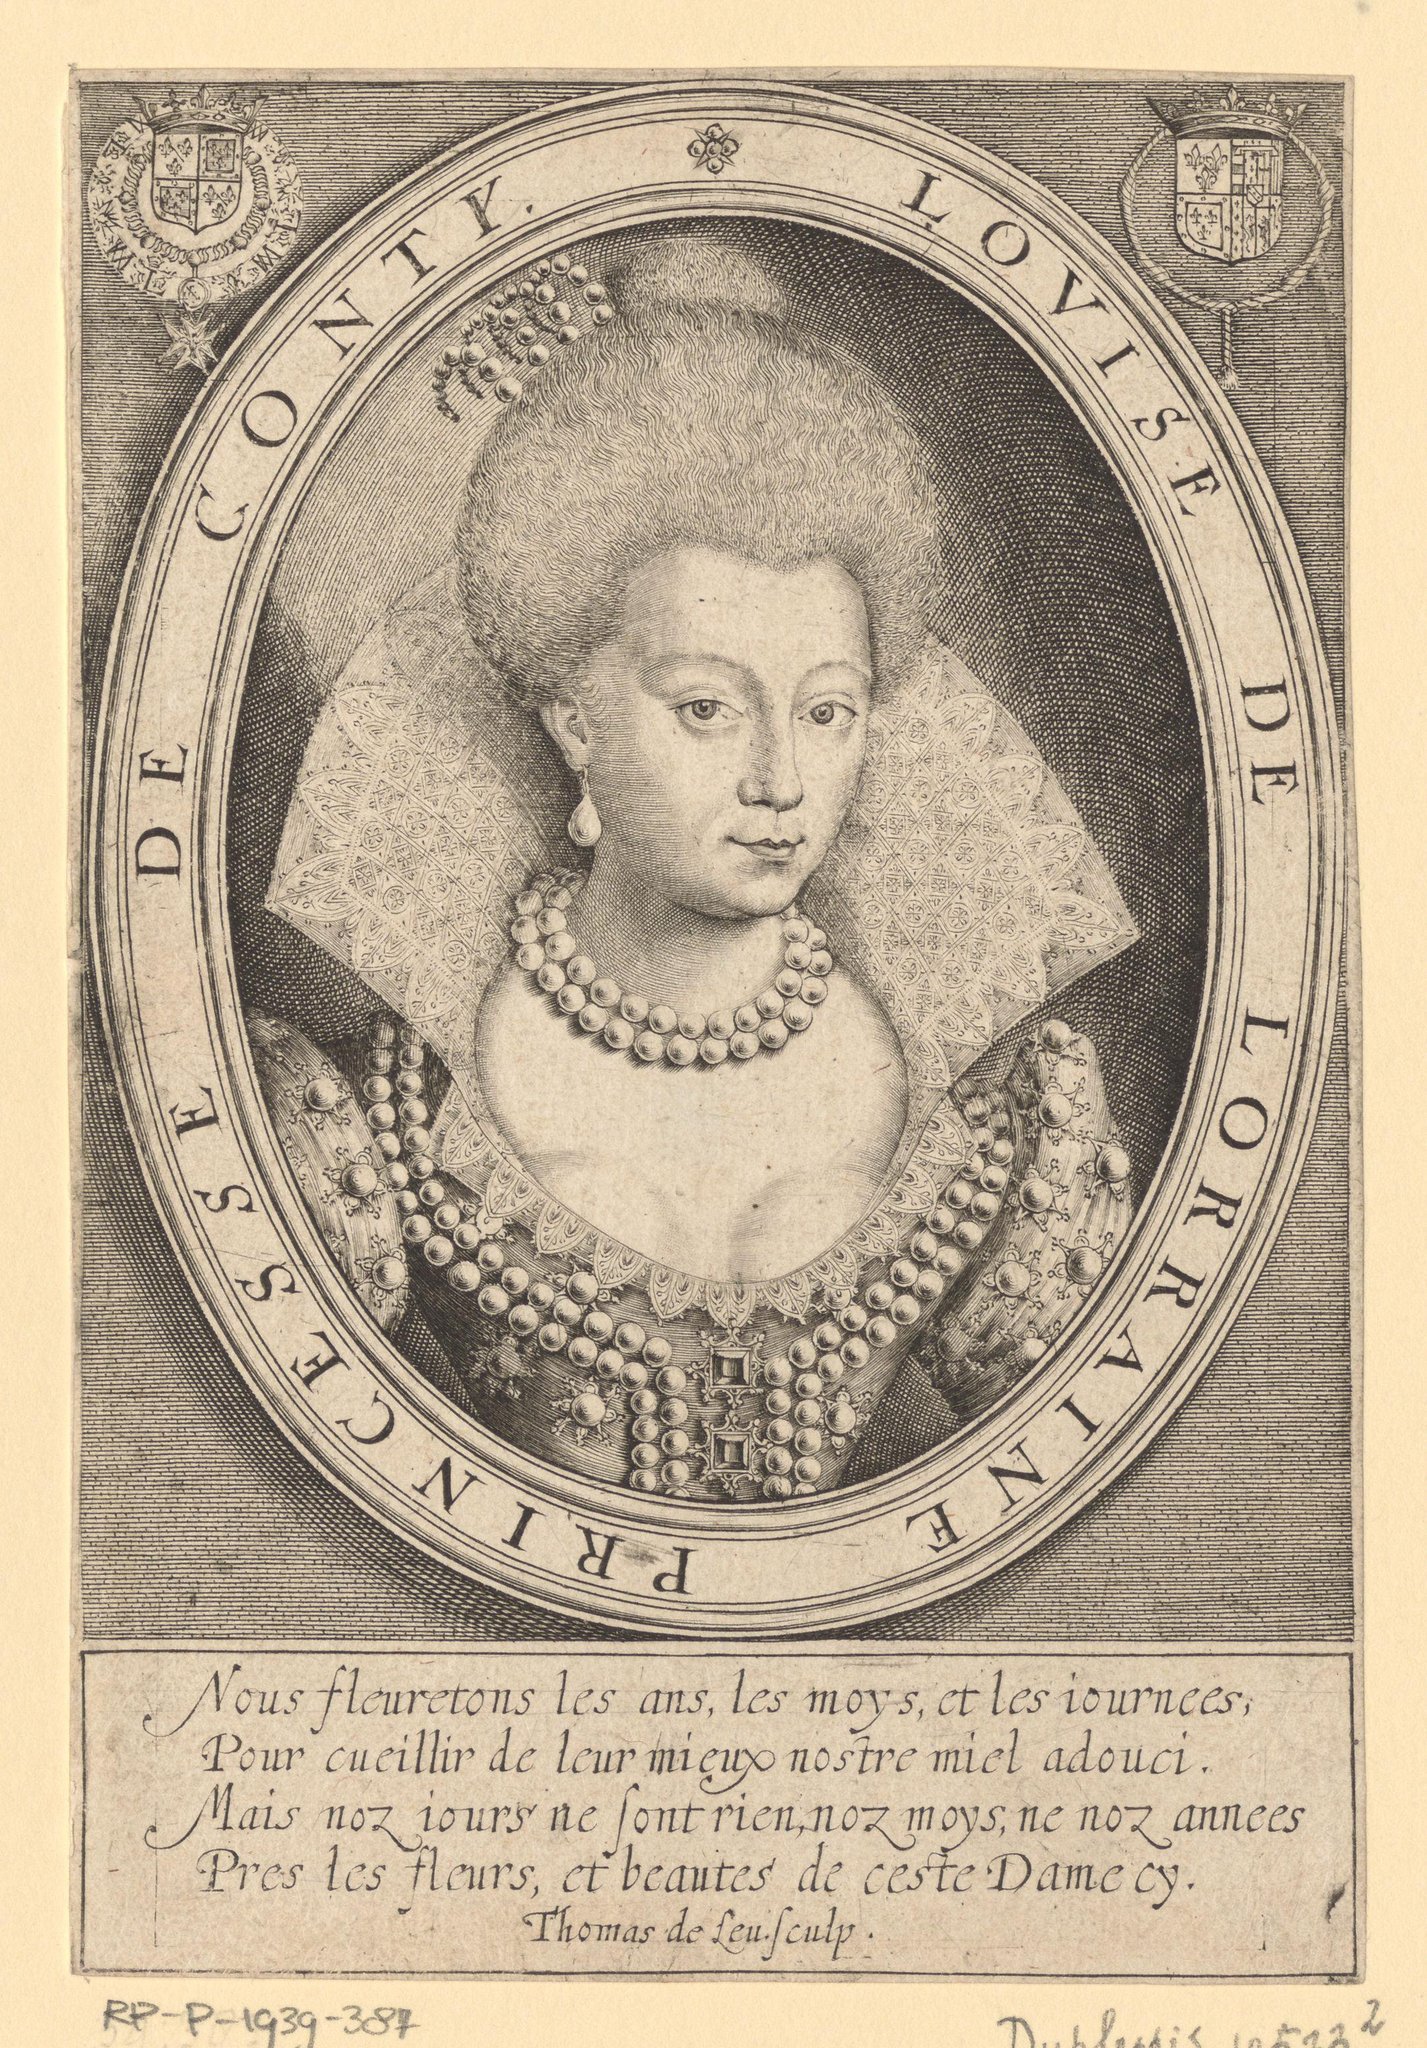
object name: print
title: Portret van Louise van Lotharingen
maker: thomas de leu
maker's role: print maker, publisher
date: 1576-1614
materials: paper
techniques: engraving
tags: historical persons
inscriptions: collector's mark: Lugt 2166, collector's mark: Lugt 130, collector's mark: Lugt 2760, collector's mark: Lugt 119